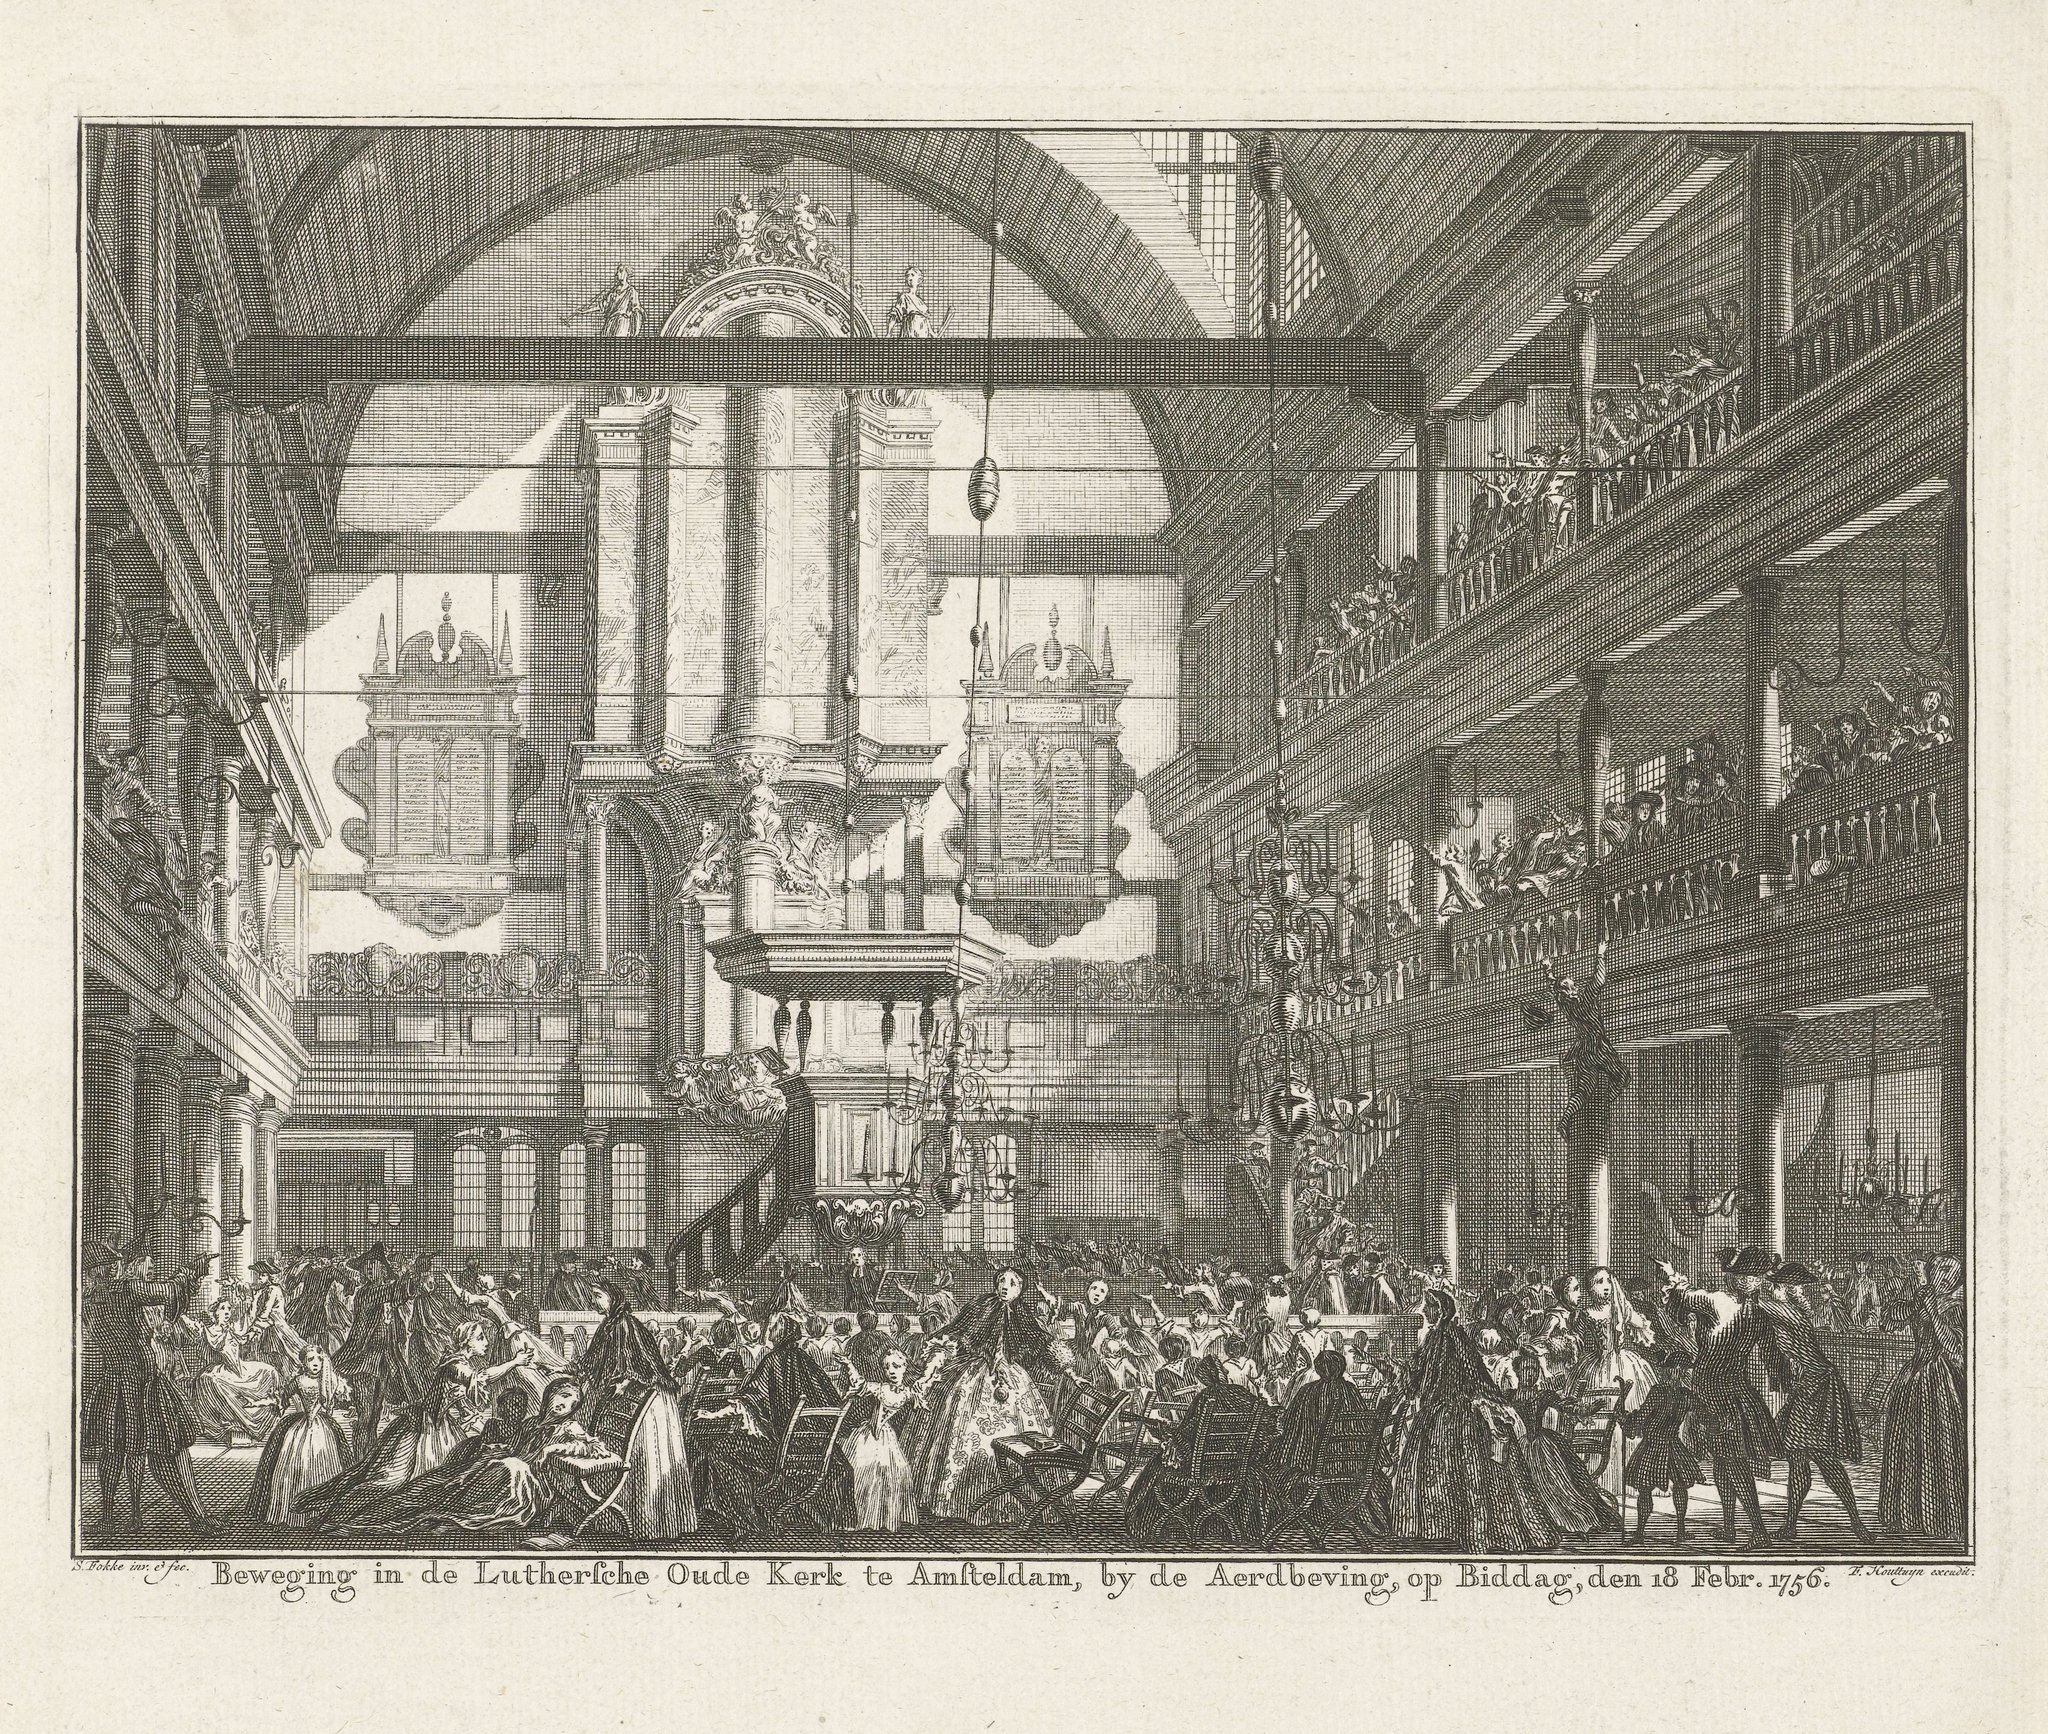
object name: book illustration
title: Beweging in de Luthersche Oude Kerk te Amsteldam, by de Aerdbeving, op Biddag, den 18 Febr. 1756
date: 1756-1757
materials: paper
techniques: engraving, etching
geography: amsterdam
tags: protestant churches and denominations (lutherans), interior of church, earthquake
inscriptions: collector's mark: Lugt 2228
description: Prent ook gebruikt in: Nederlandsche Jaerboeken, inhoudende een verhael van de merkwaerdigste geschiedenissen (…) Tiende deel. 1756. Amsterdam: Frans Houttuyn, s.a. [1756-1757], tussen p. 202 en 203.